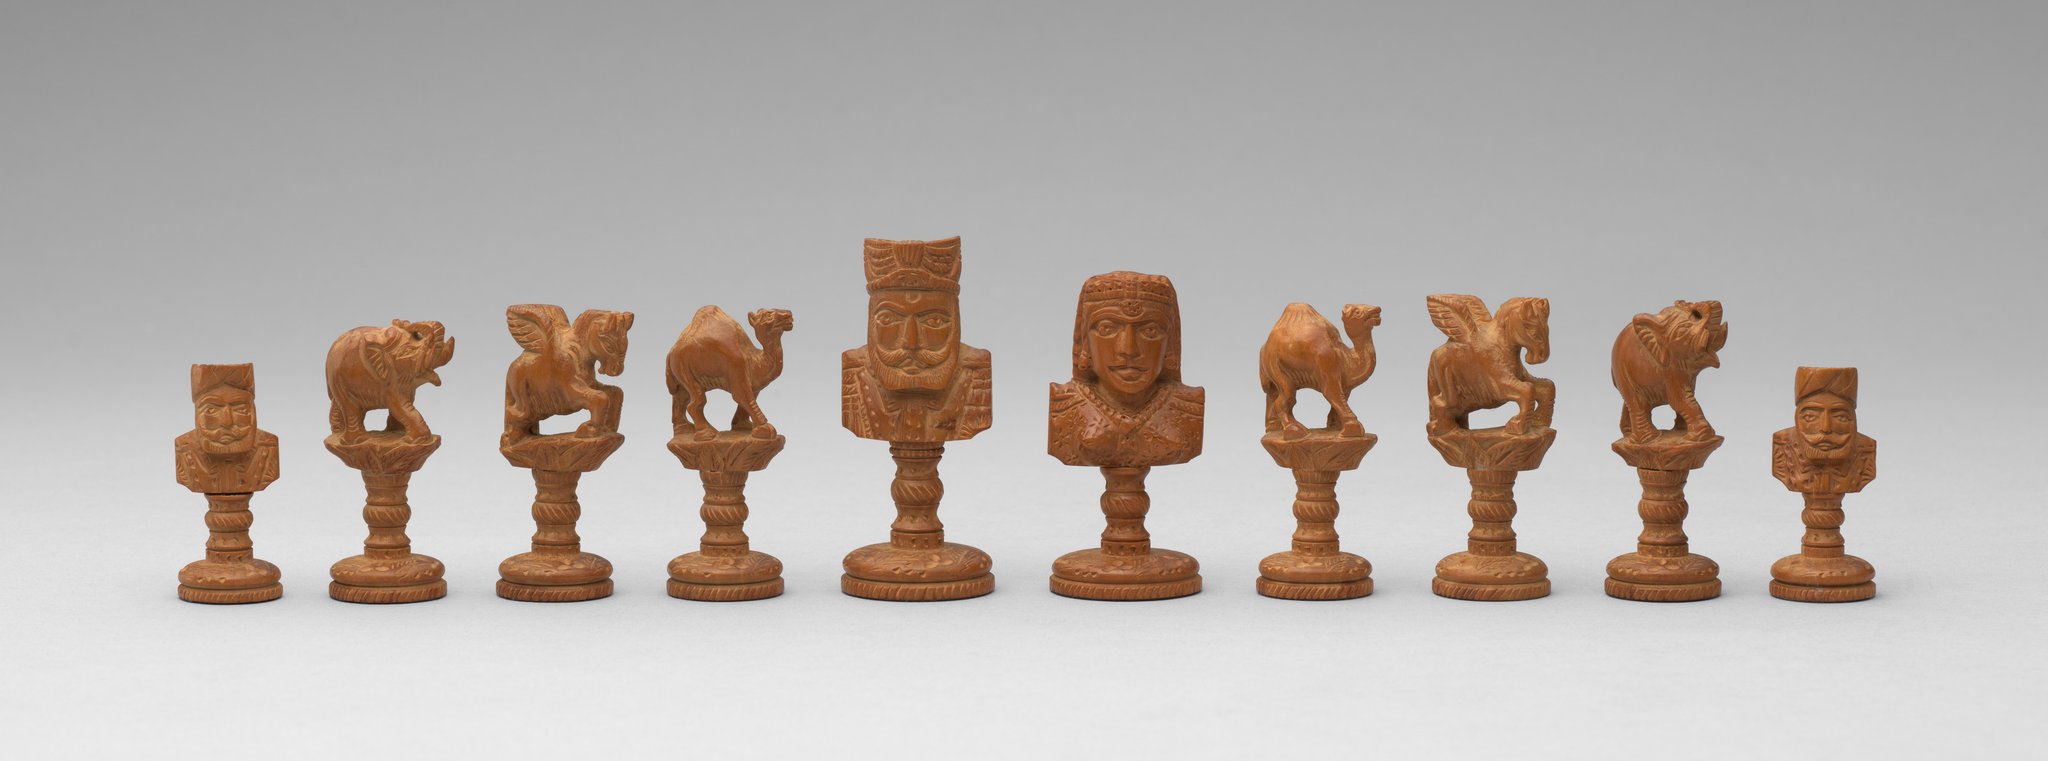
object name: chessman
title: Chessmen (32)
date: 1851-1900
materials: wood